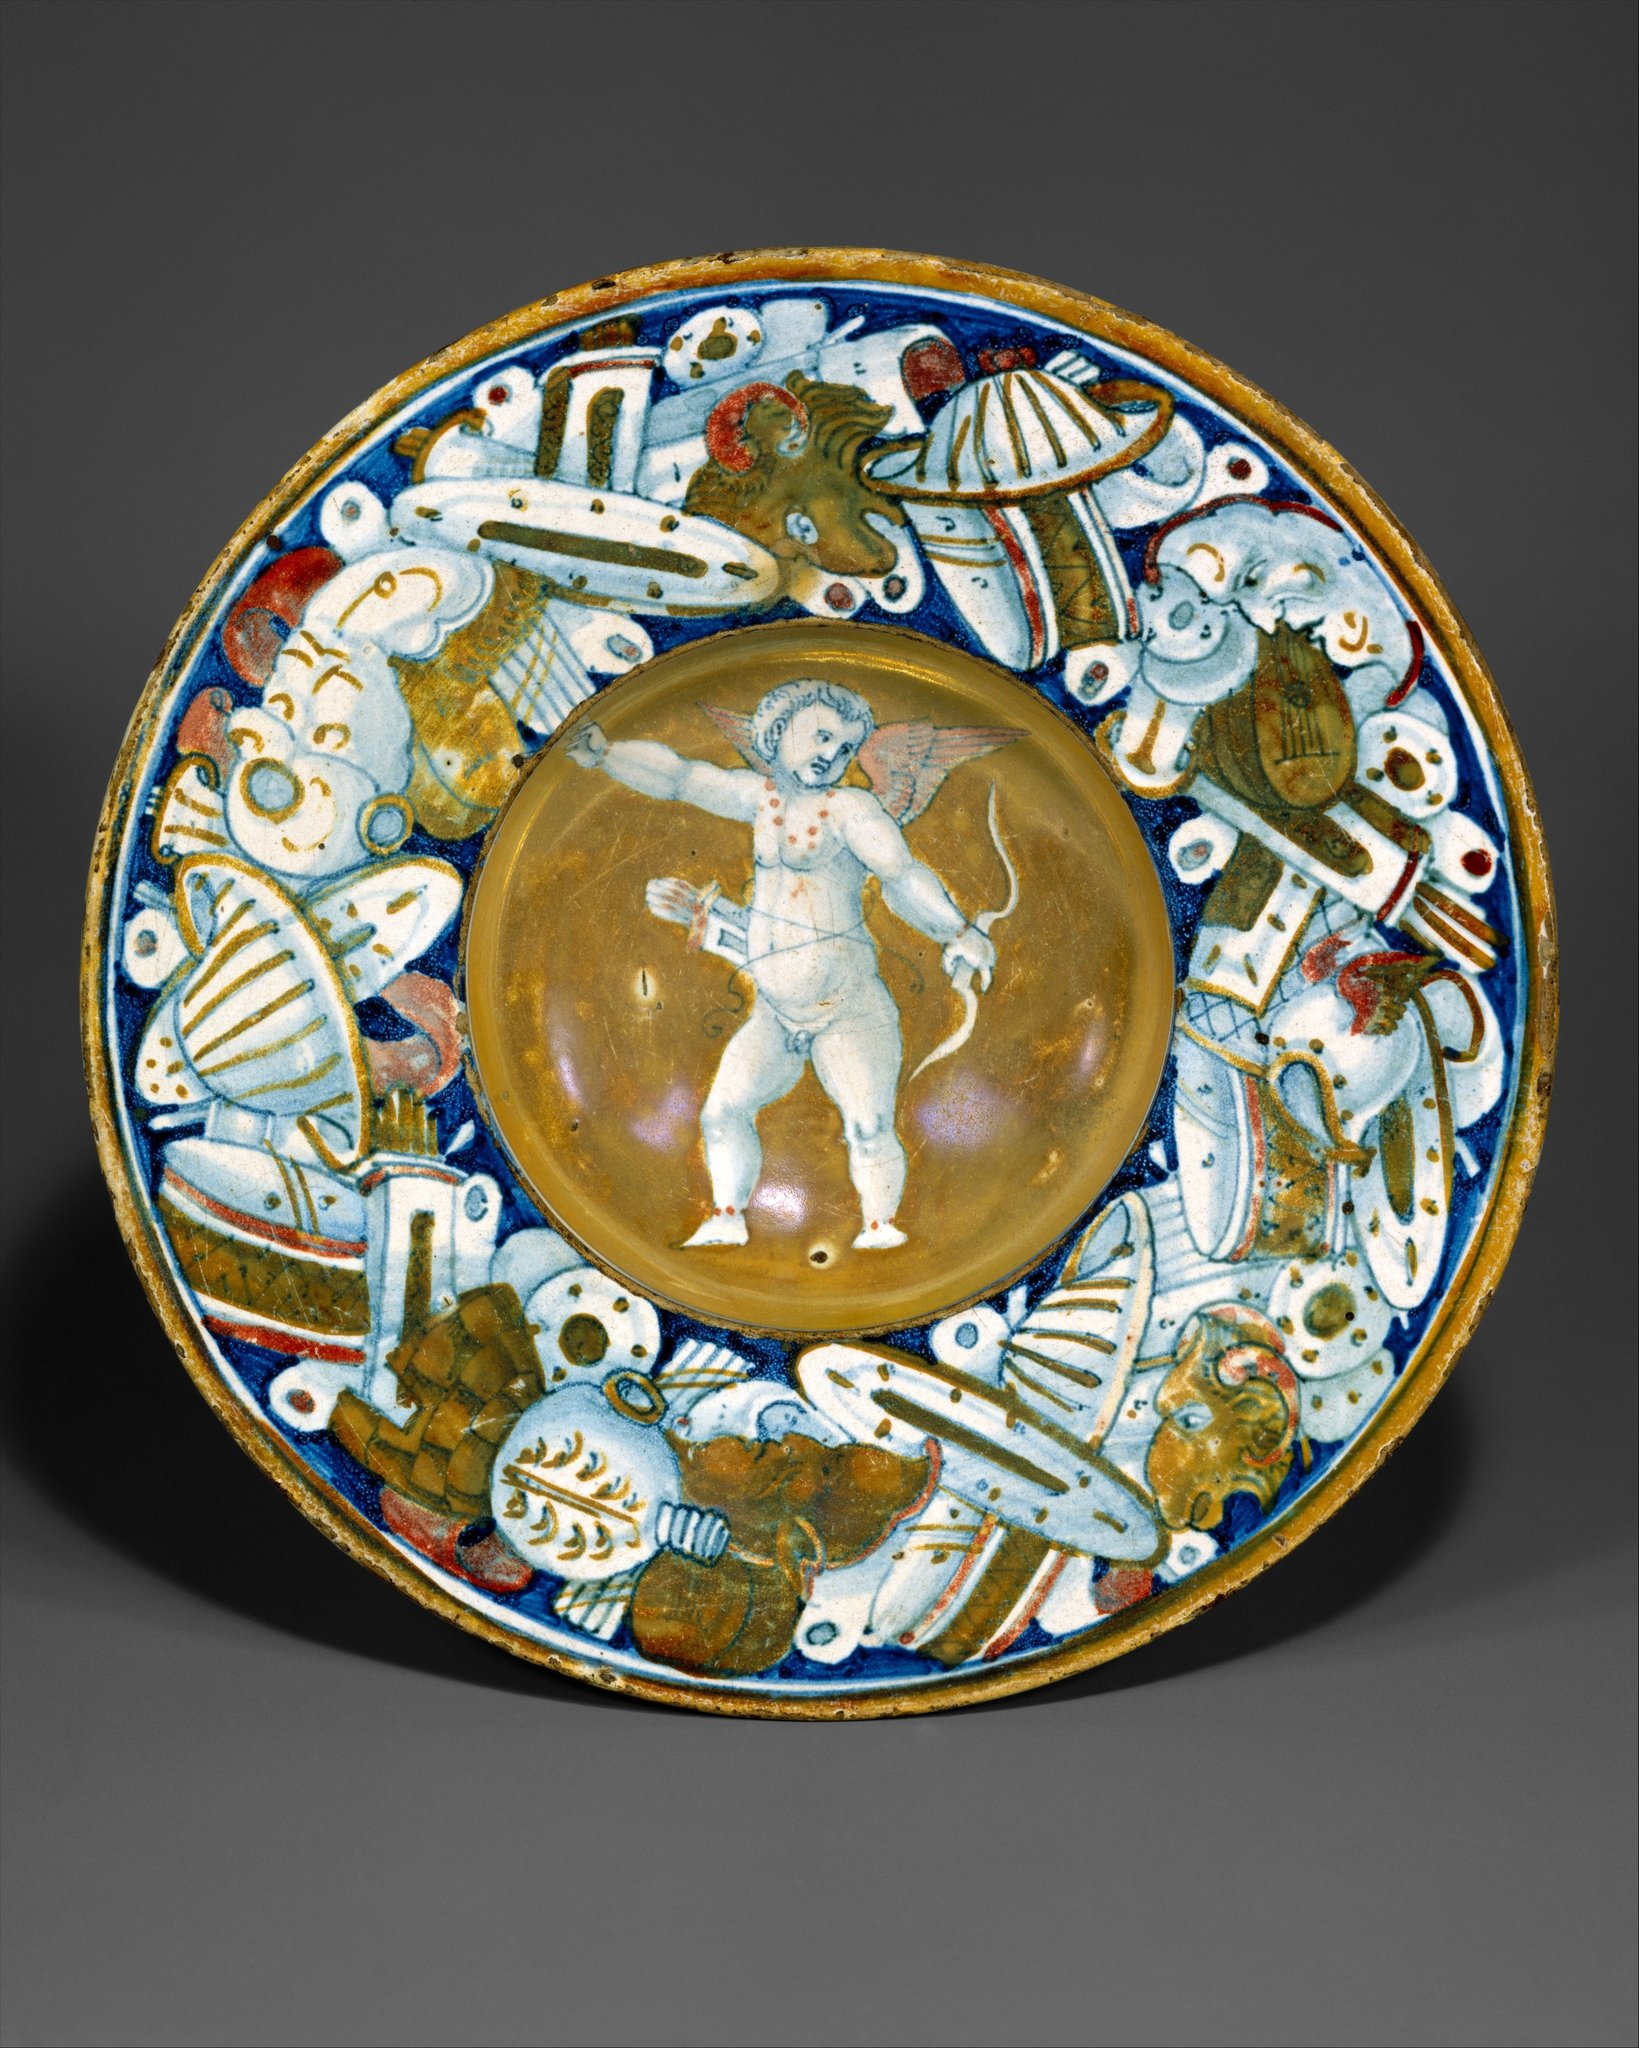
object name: dish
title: Dish (tondino)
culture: italian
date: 1530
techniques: maiolica, glazing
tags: cupid